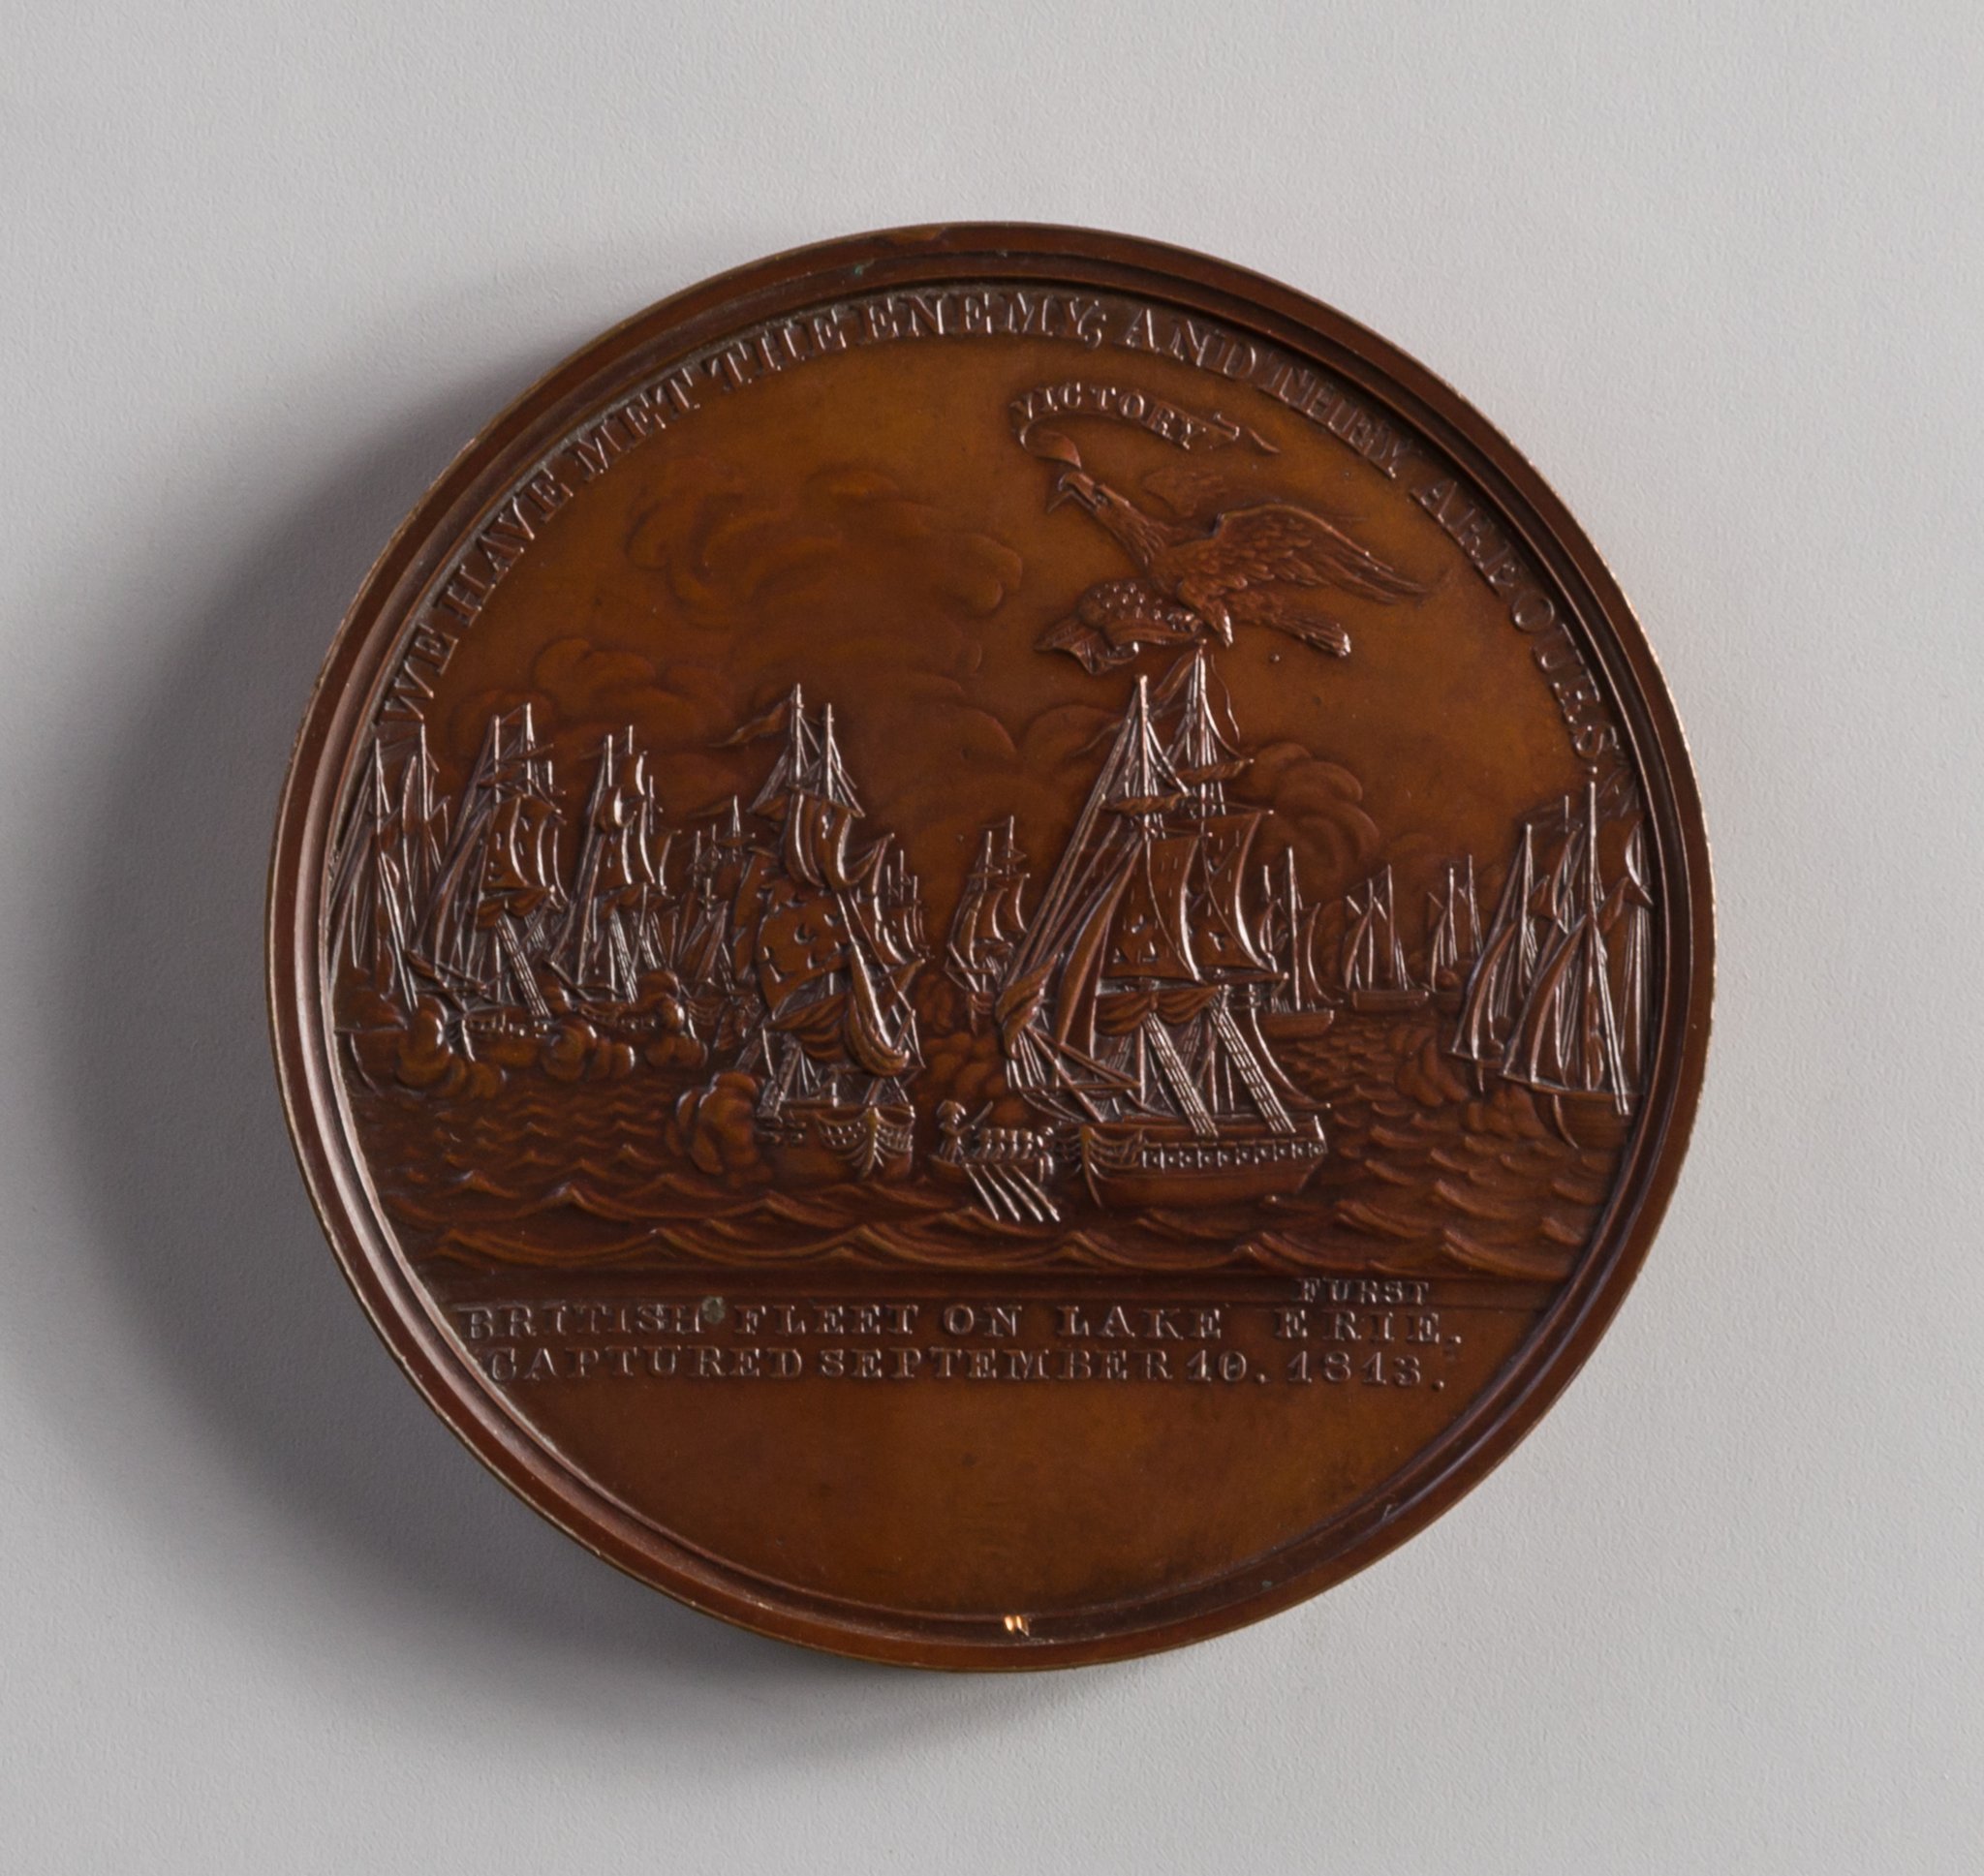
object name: medal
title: Medal of the Naval Battle of Lake Erie, 1813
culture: american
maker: moritz fürst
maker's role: maker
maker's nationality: hungarian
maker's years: 1782-1882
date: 1801-1900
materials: bronze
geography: united states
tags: birds,battles,lakes,ships